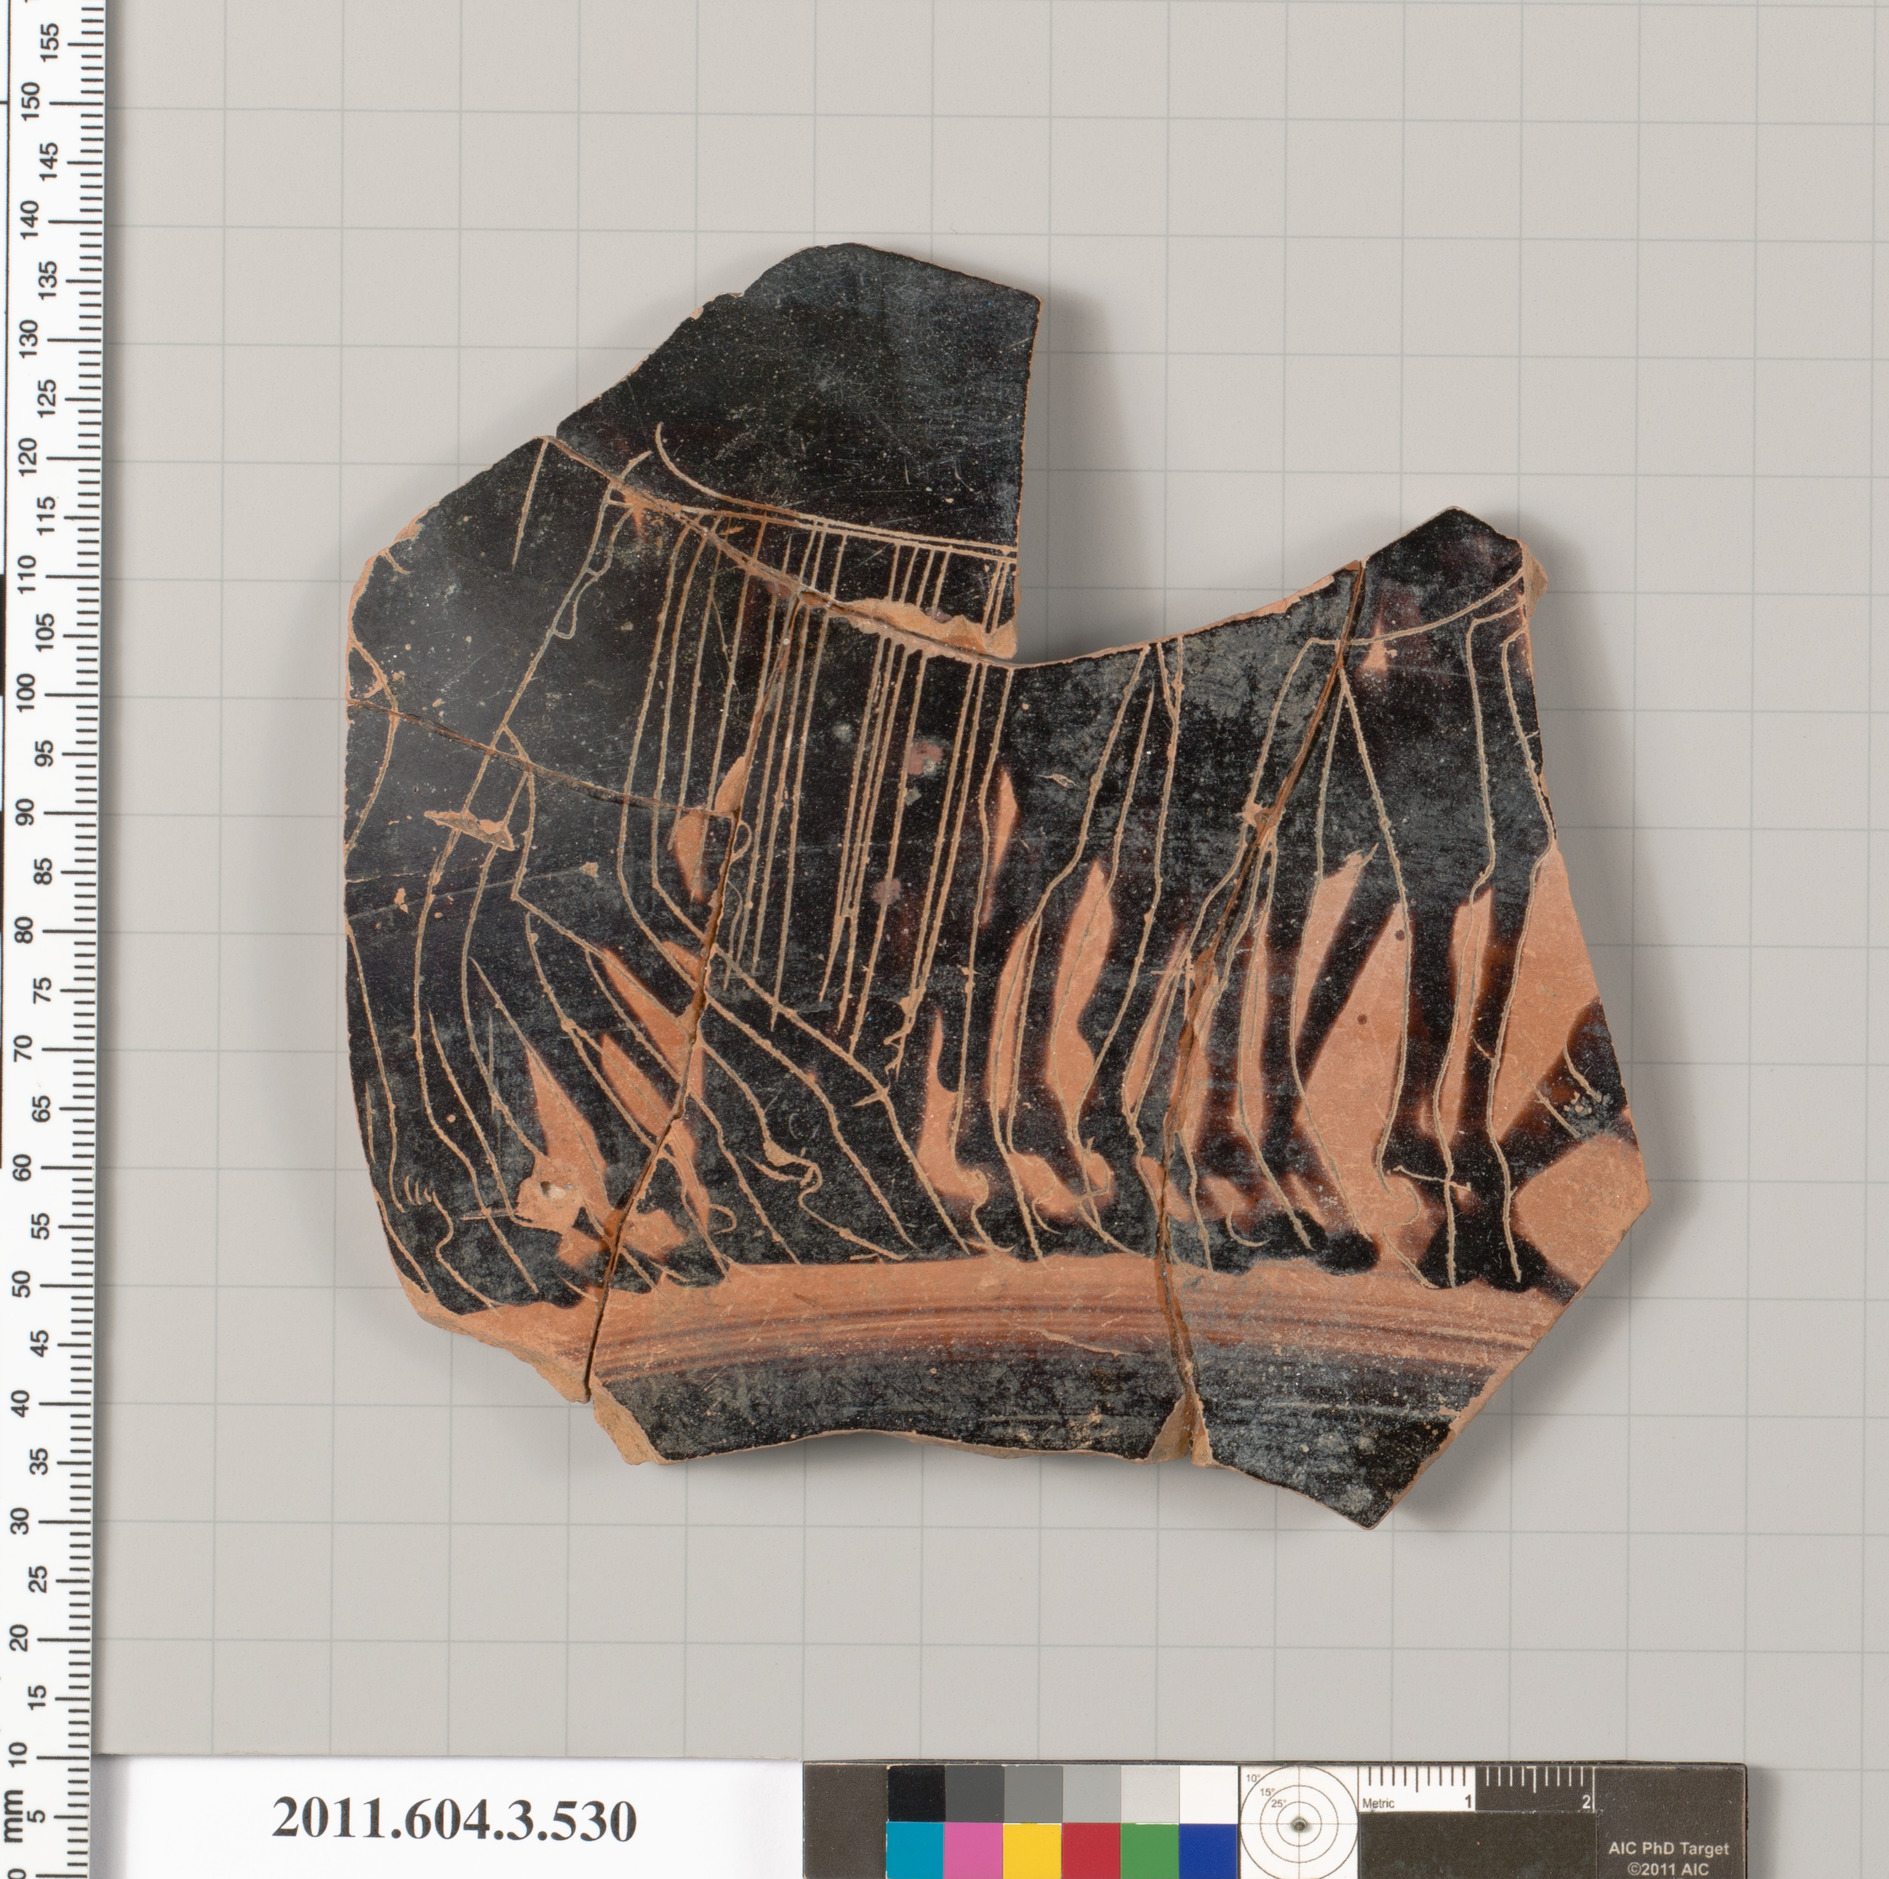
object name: column krater fragment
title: Terracotta fragment of a column-krater (bowl for mixing wine and water)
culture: greek, attic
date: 534-468 BCE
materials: terracotta